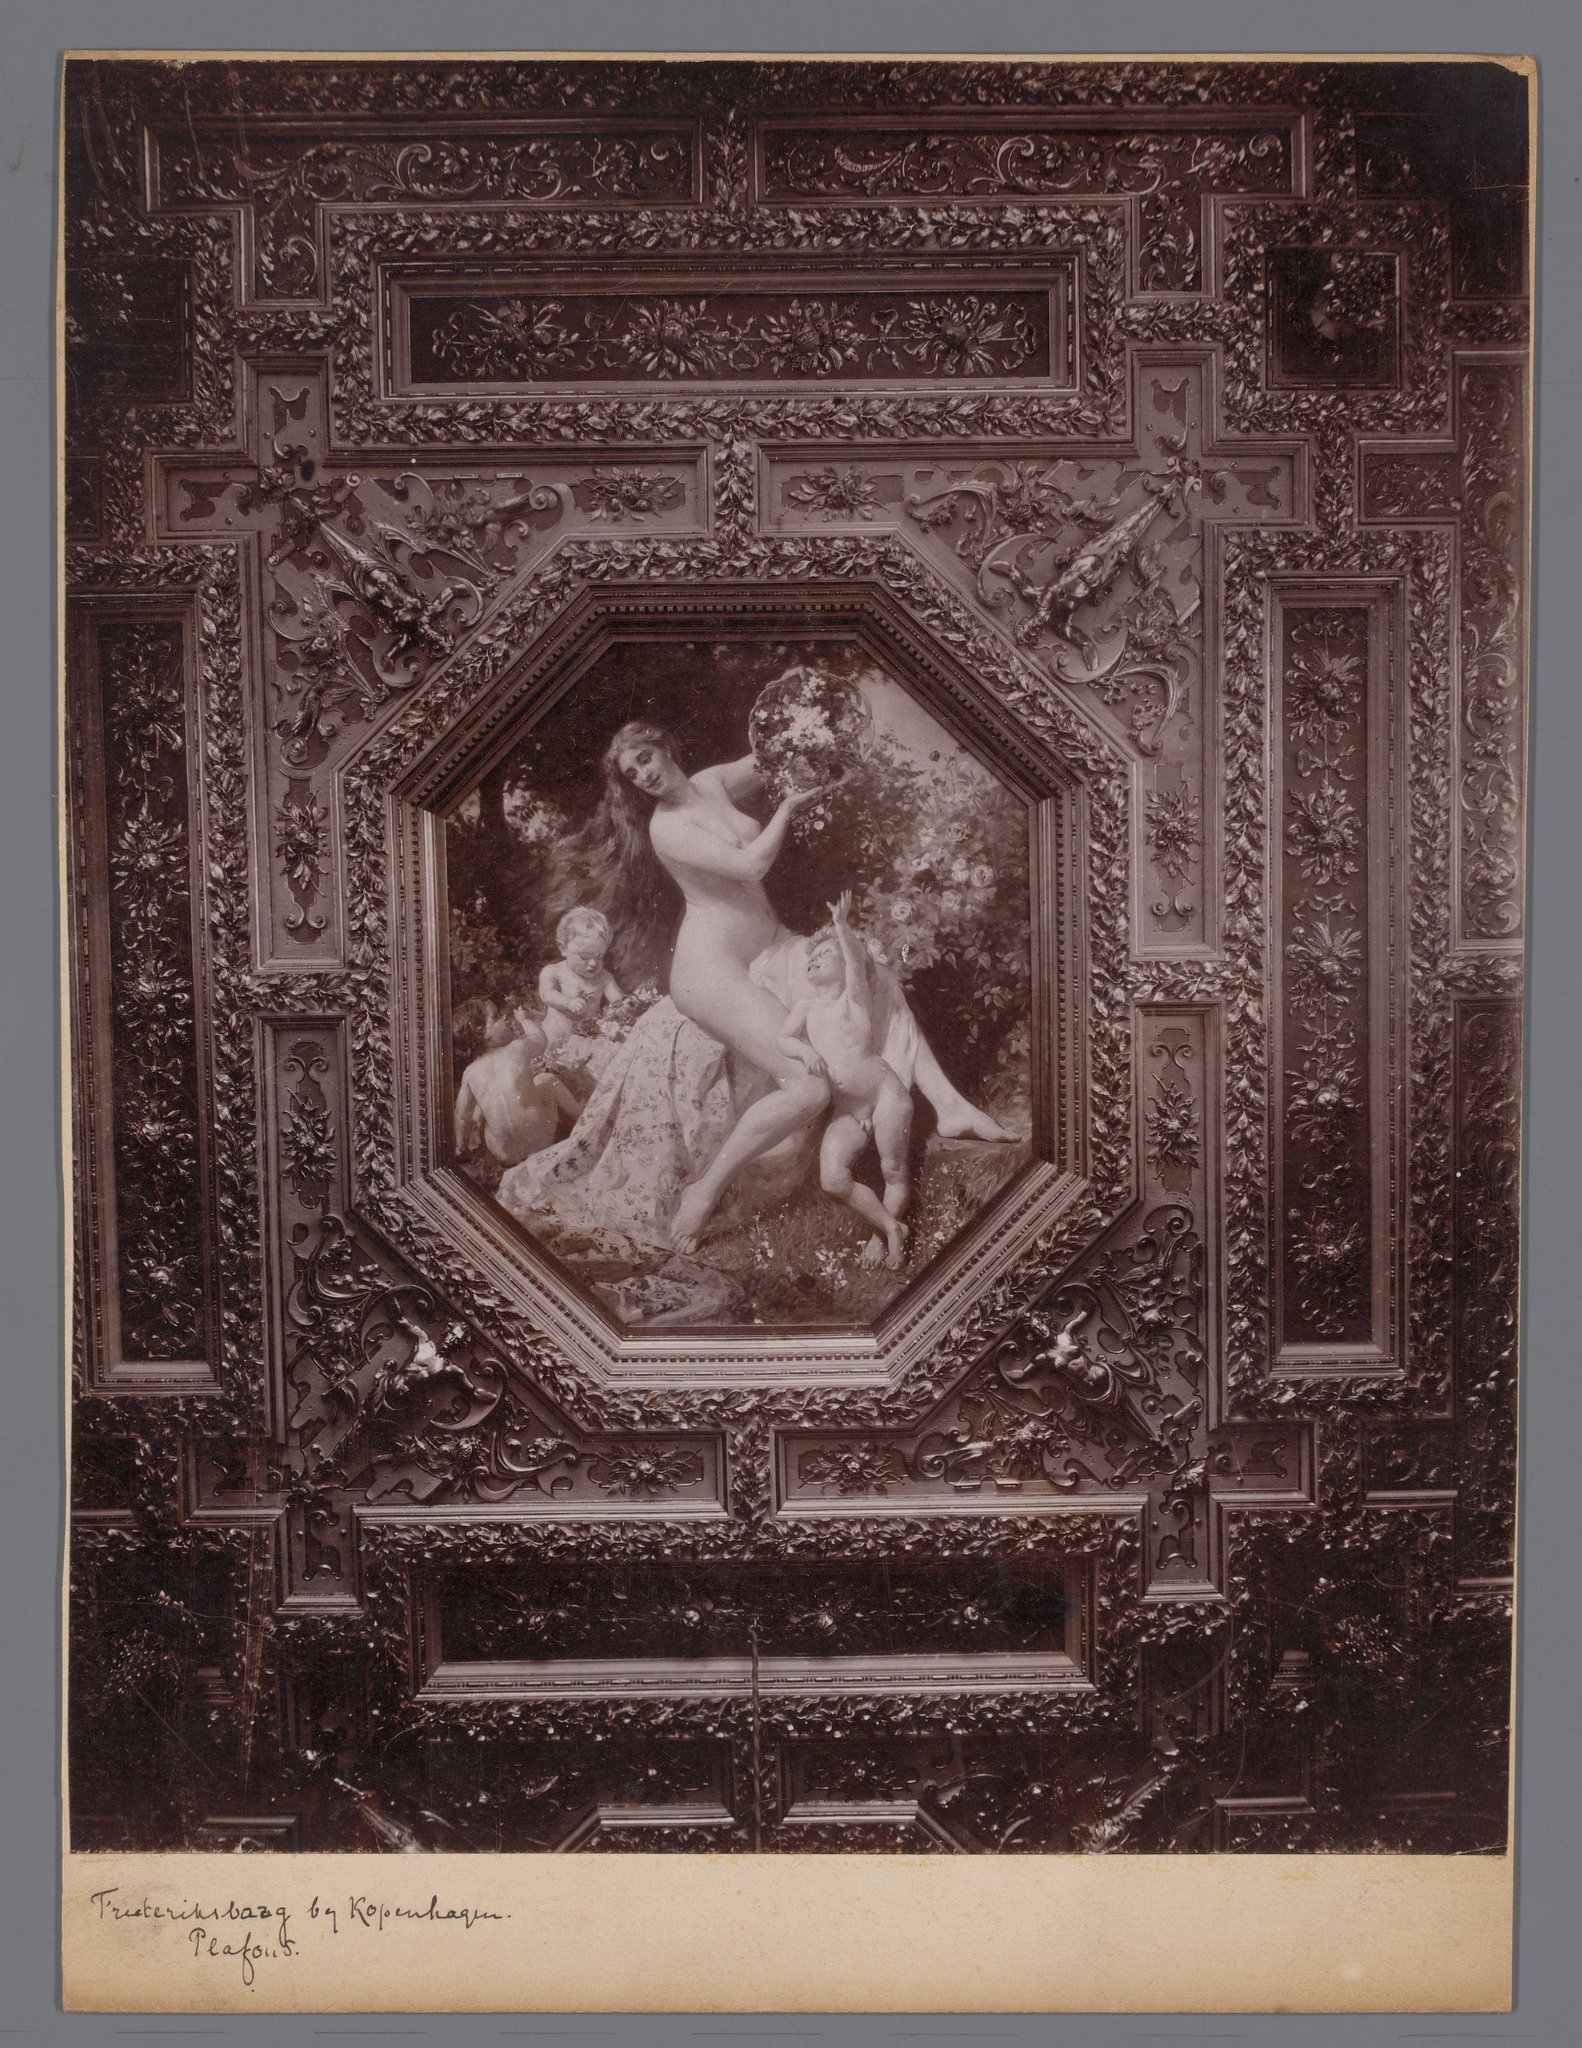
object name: photograph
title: Frederiksborg bij Kopenhagen, plafond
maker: Anonymous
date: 1880-1910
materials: paper, cardboard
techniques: collodion silver print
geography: hillerød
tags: (decorated) ceiling